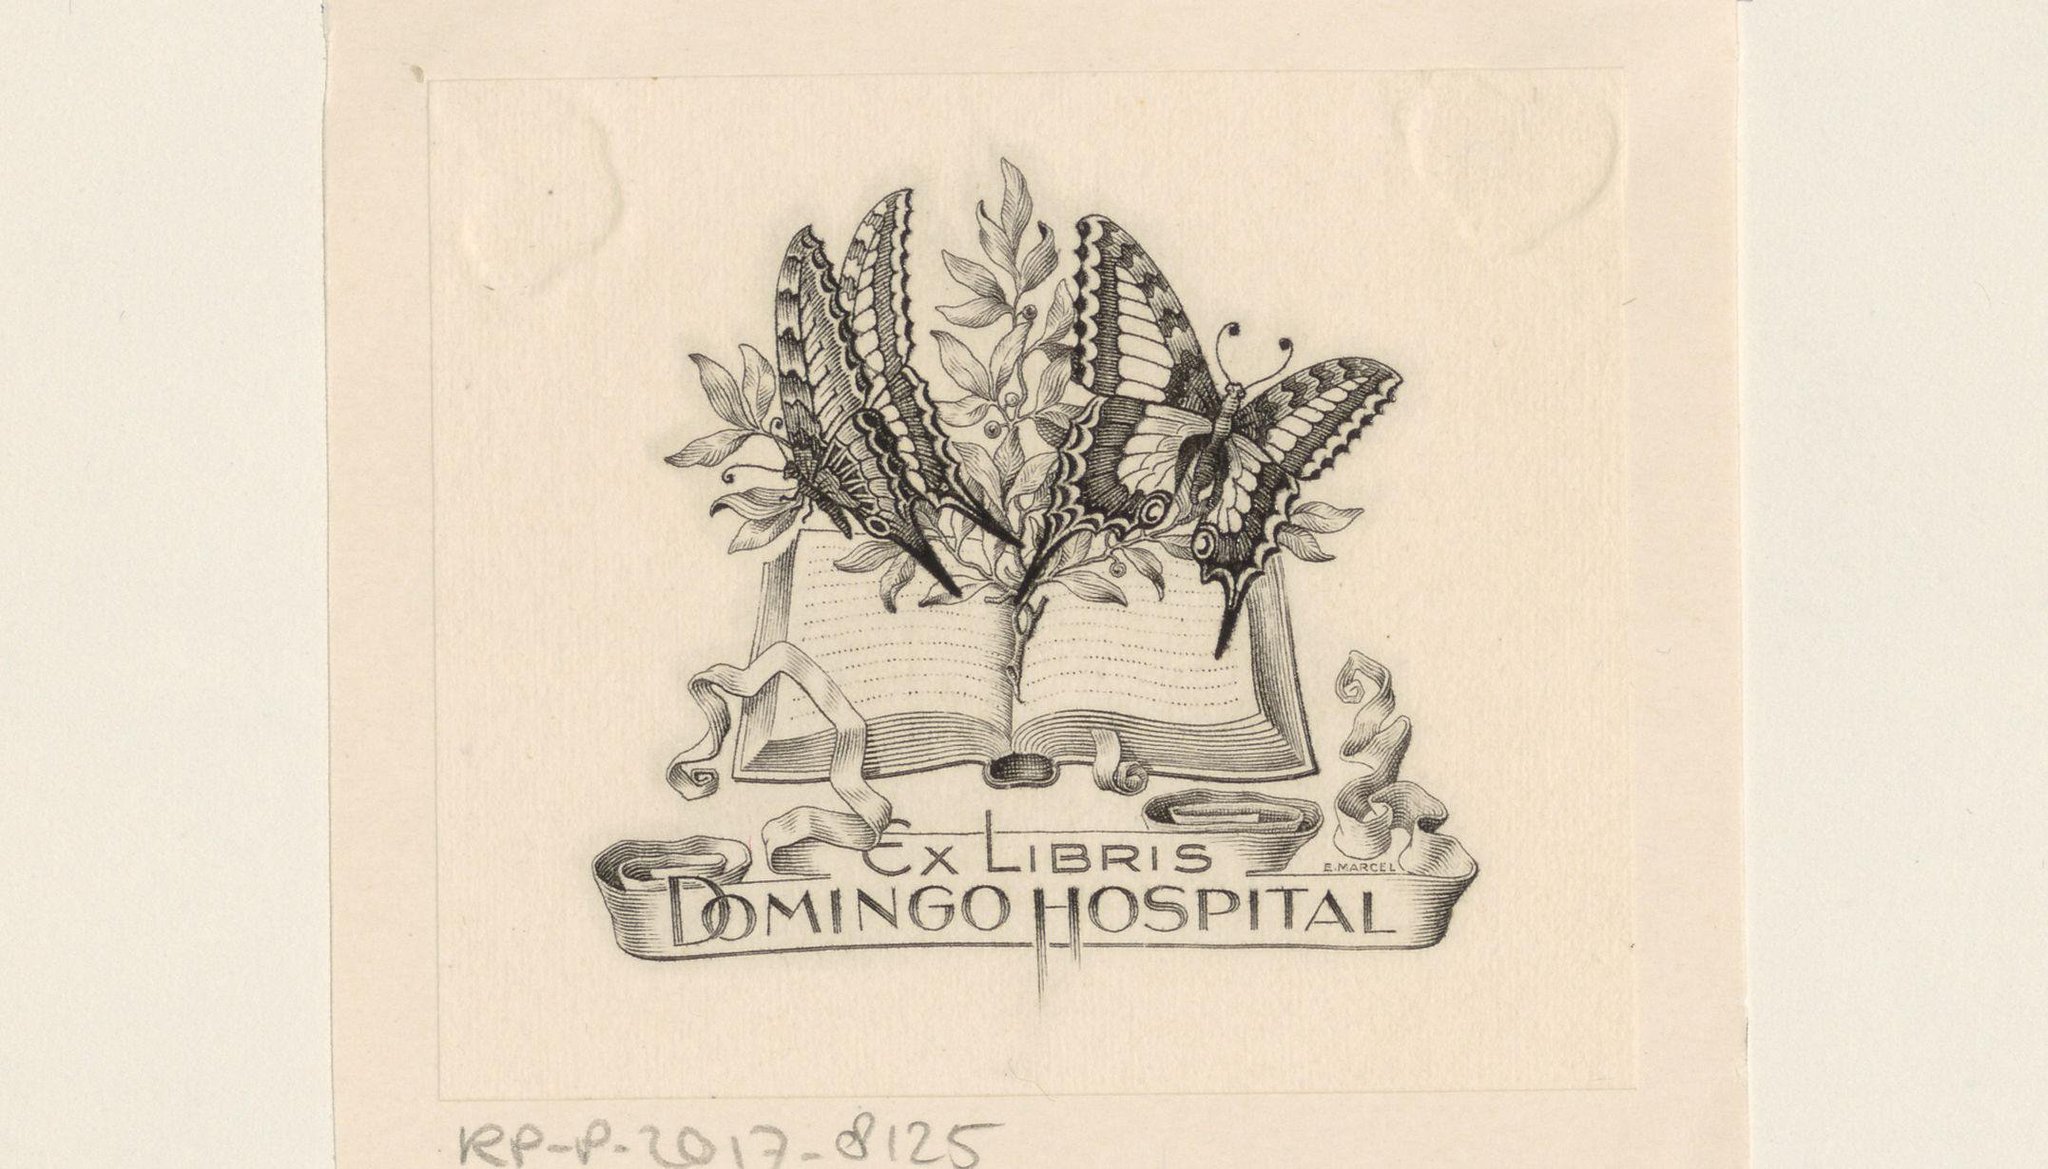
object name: bookplate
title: Ex libris van Domingo Hospital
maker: e. marcel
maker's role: print maker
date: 1944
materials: paper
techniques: printing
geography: spain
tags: book, insects: butterfly